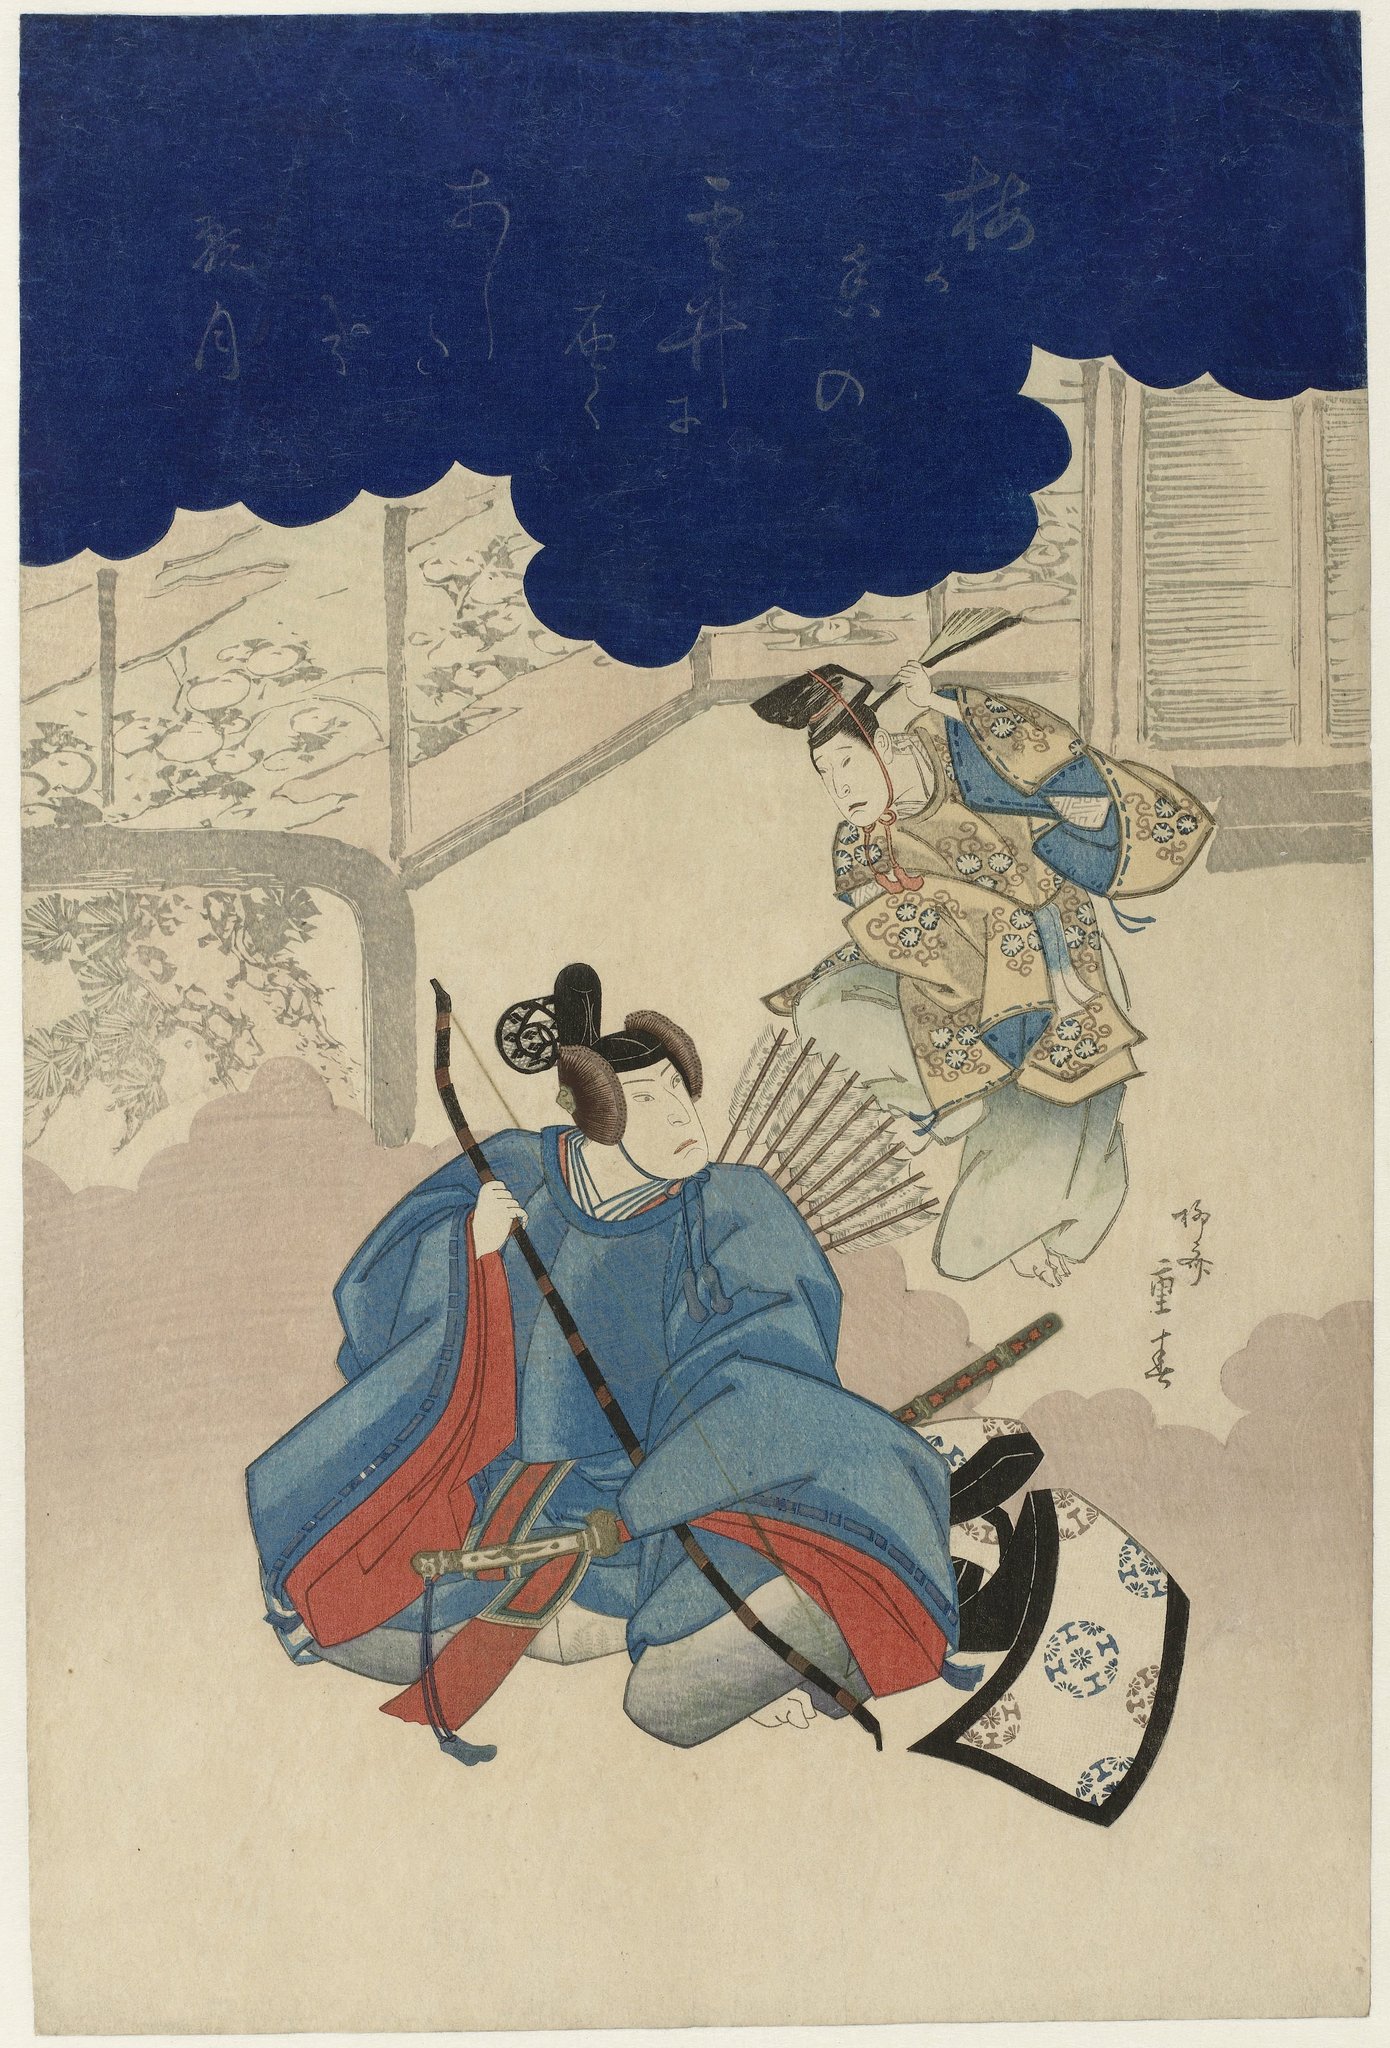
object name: print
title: Man met boog denkend aan dansende man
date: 1801-1834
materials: paper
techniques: woodcut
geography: osaka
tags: japan, archer's weapons: bow and arrow, portrait of actor, actress, man dancing alone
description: Toneelspeler Nakamura Shikan II in de rol van Ariwara no Narihira met boog, denkend aan zichzelf in de rol van Bunya no Yasuhide, de dansende man op de achtergrond. Het toneelstuk ‘Rokkasen sugata no saishiki’ werd opgevoerd in de eerste maand van 1834 in het Kado Theater.